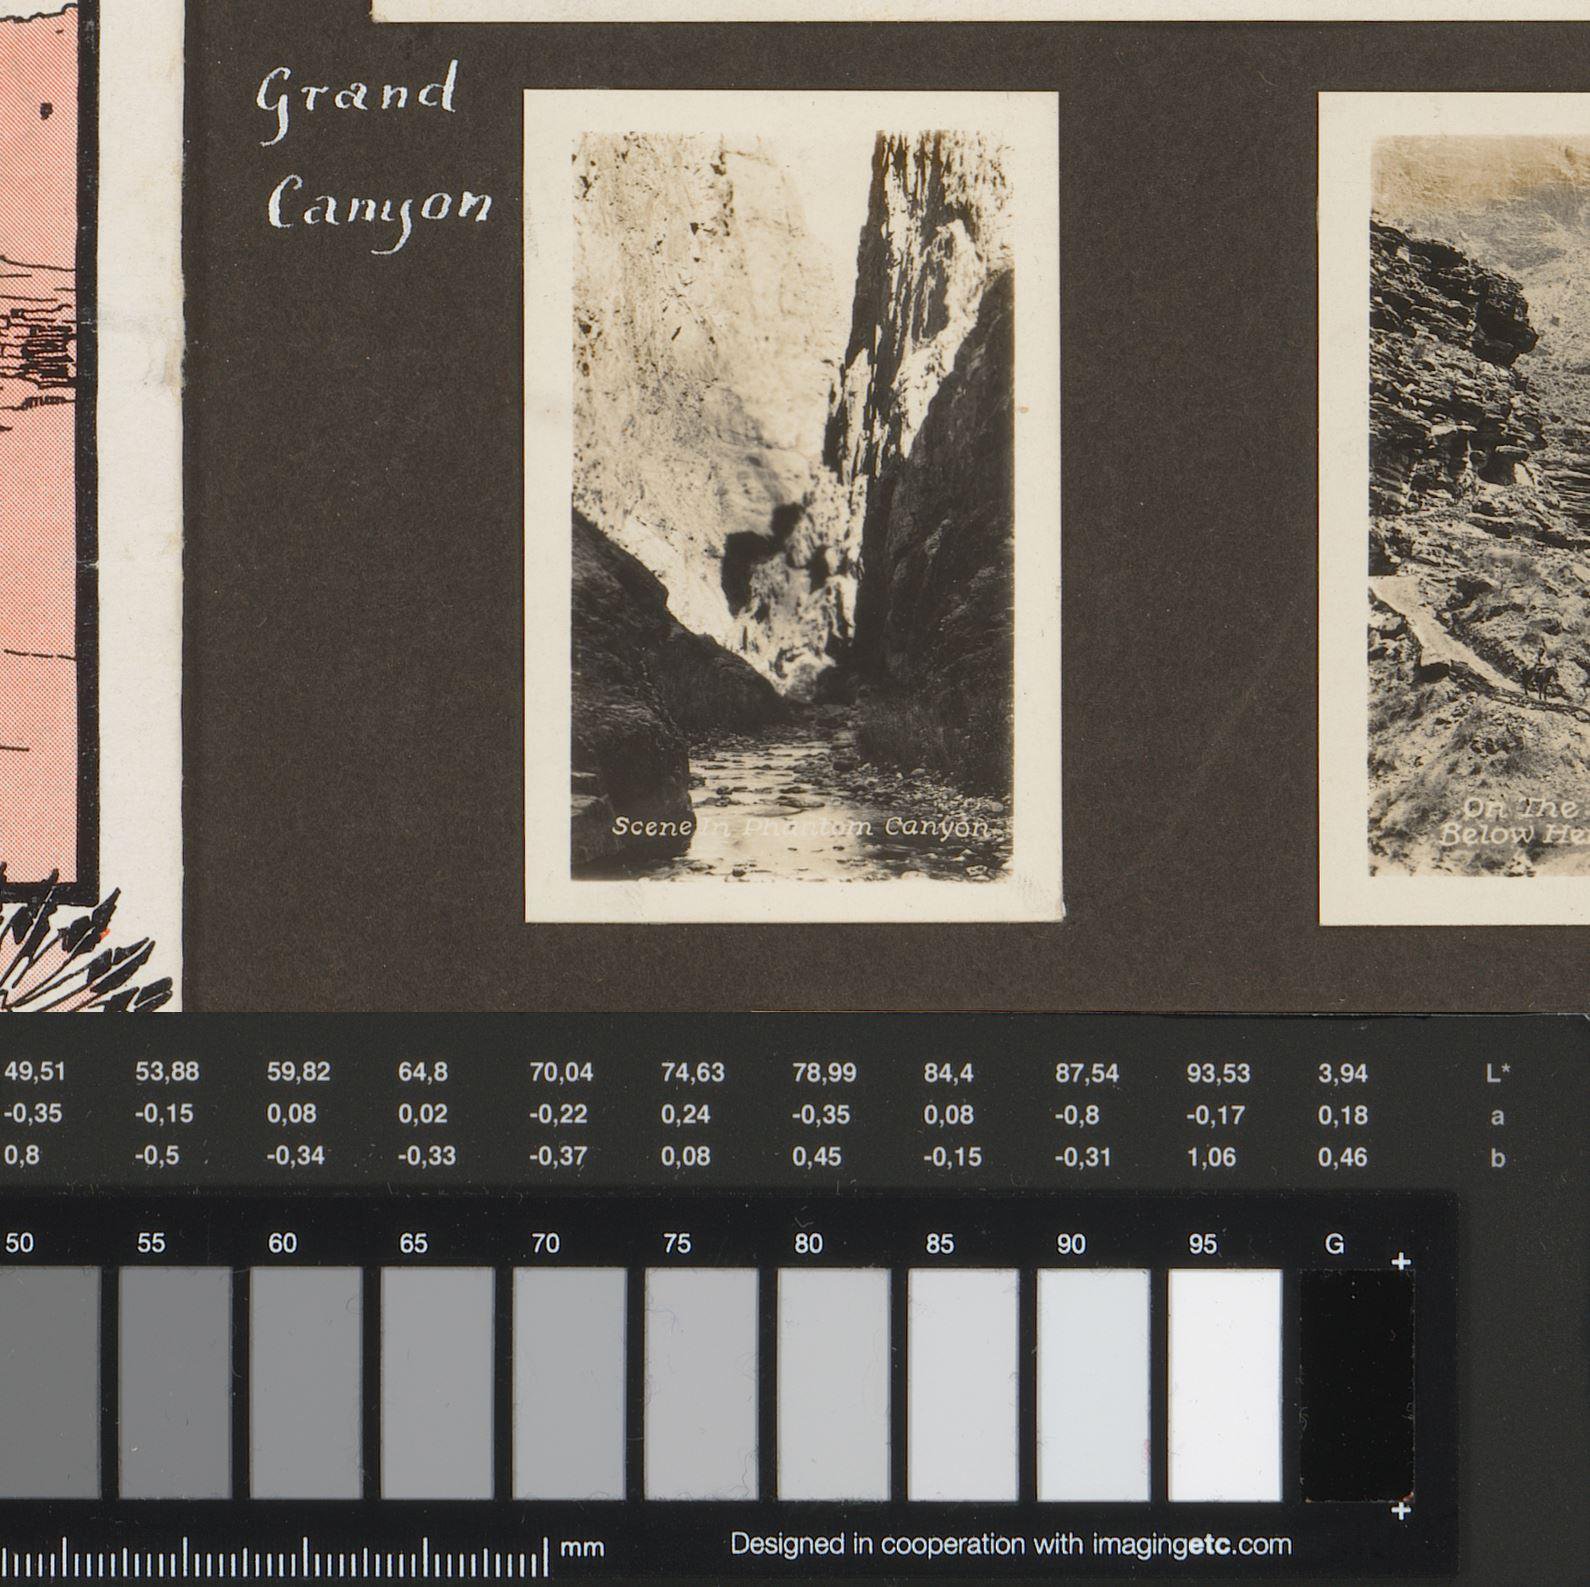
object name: photograph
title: Gezicht op Phantom Canyon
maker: Anonymous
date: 1928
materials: photographic support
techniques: gelatin silver print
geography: united states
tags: ravine, chasm, abyss, canyon, rock-formations, united states of america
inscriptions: annotation: ‘Grand Canyon’